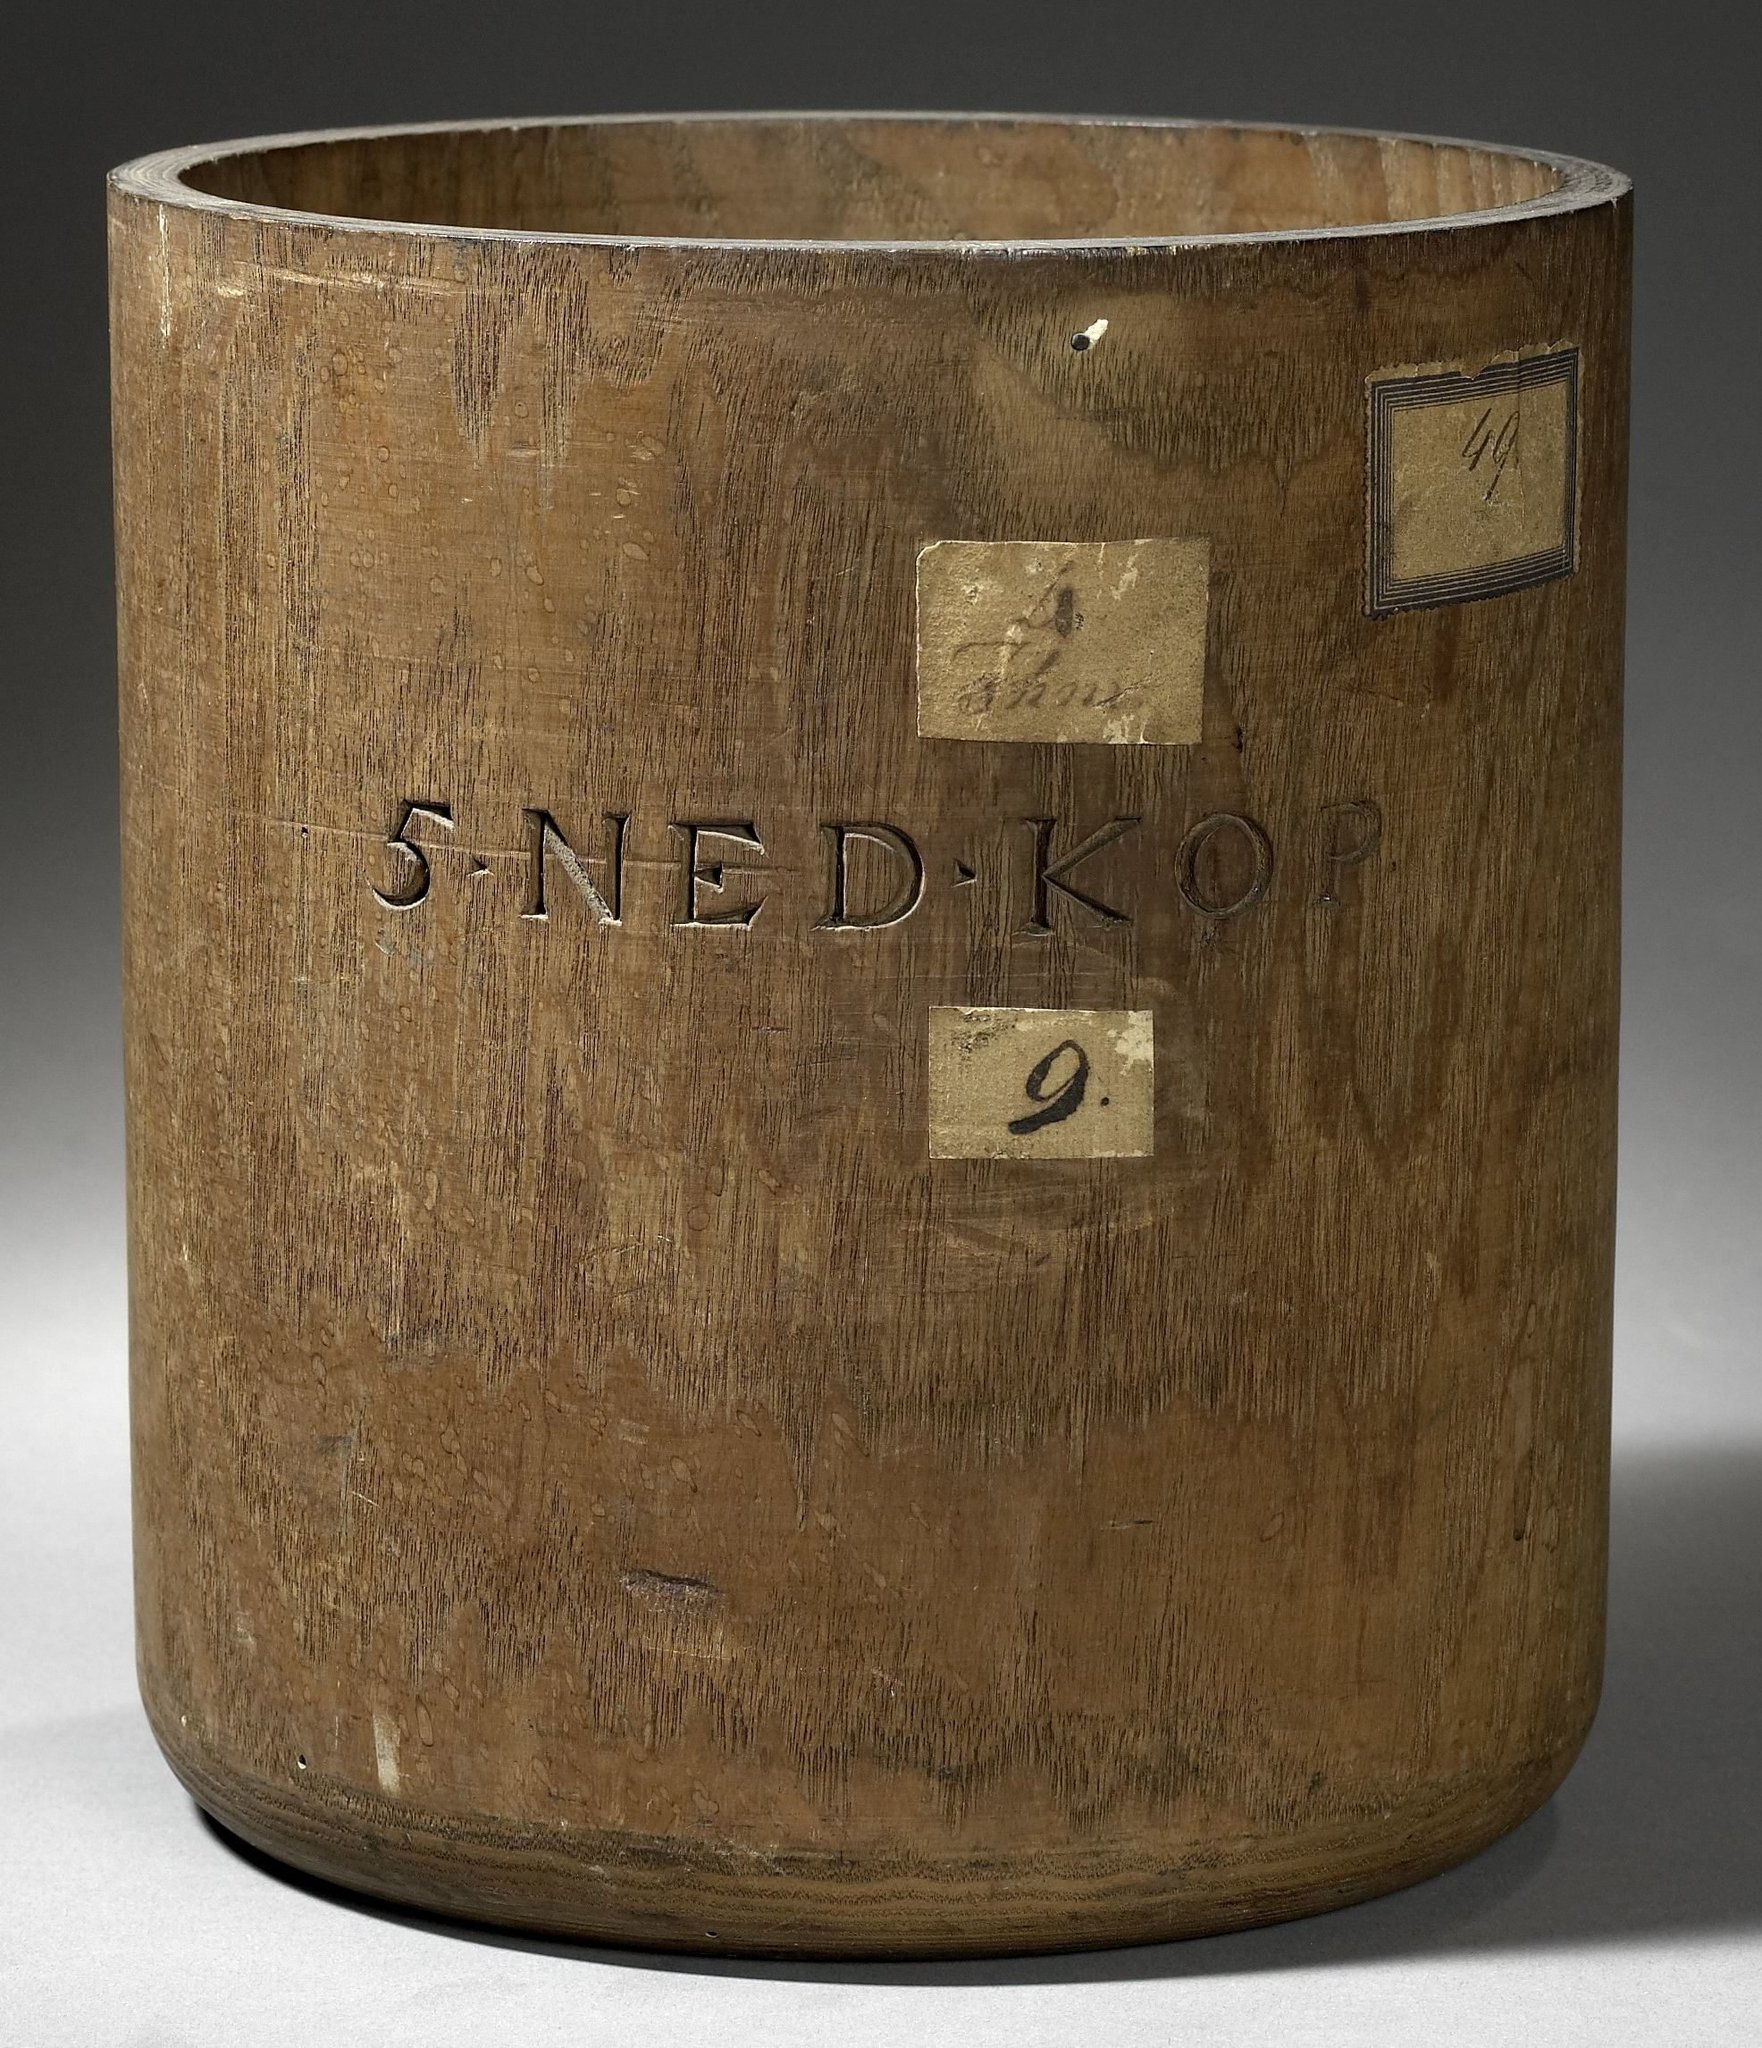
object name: inhoudsmaat droge waren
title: Inhoudsmaat van 5 l ( 5 Ned. Kop)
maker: Anonymous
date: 1830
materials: wood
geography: netherlands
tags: netherlands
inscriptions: number: ‘9’, number: ‘4 Ihm.’, number: ‘49’, title: ‘5.NED.KOP.’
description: Gedraaide houten inhoudsmaat van 5 l (5 Ned. Kop), v.z.v. etiketten en opschrift.